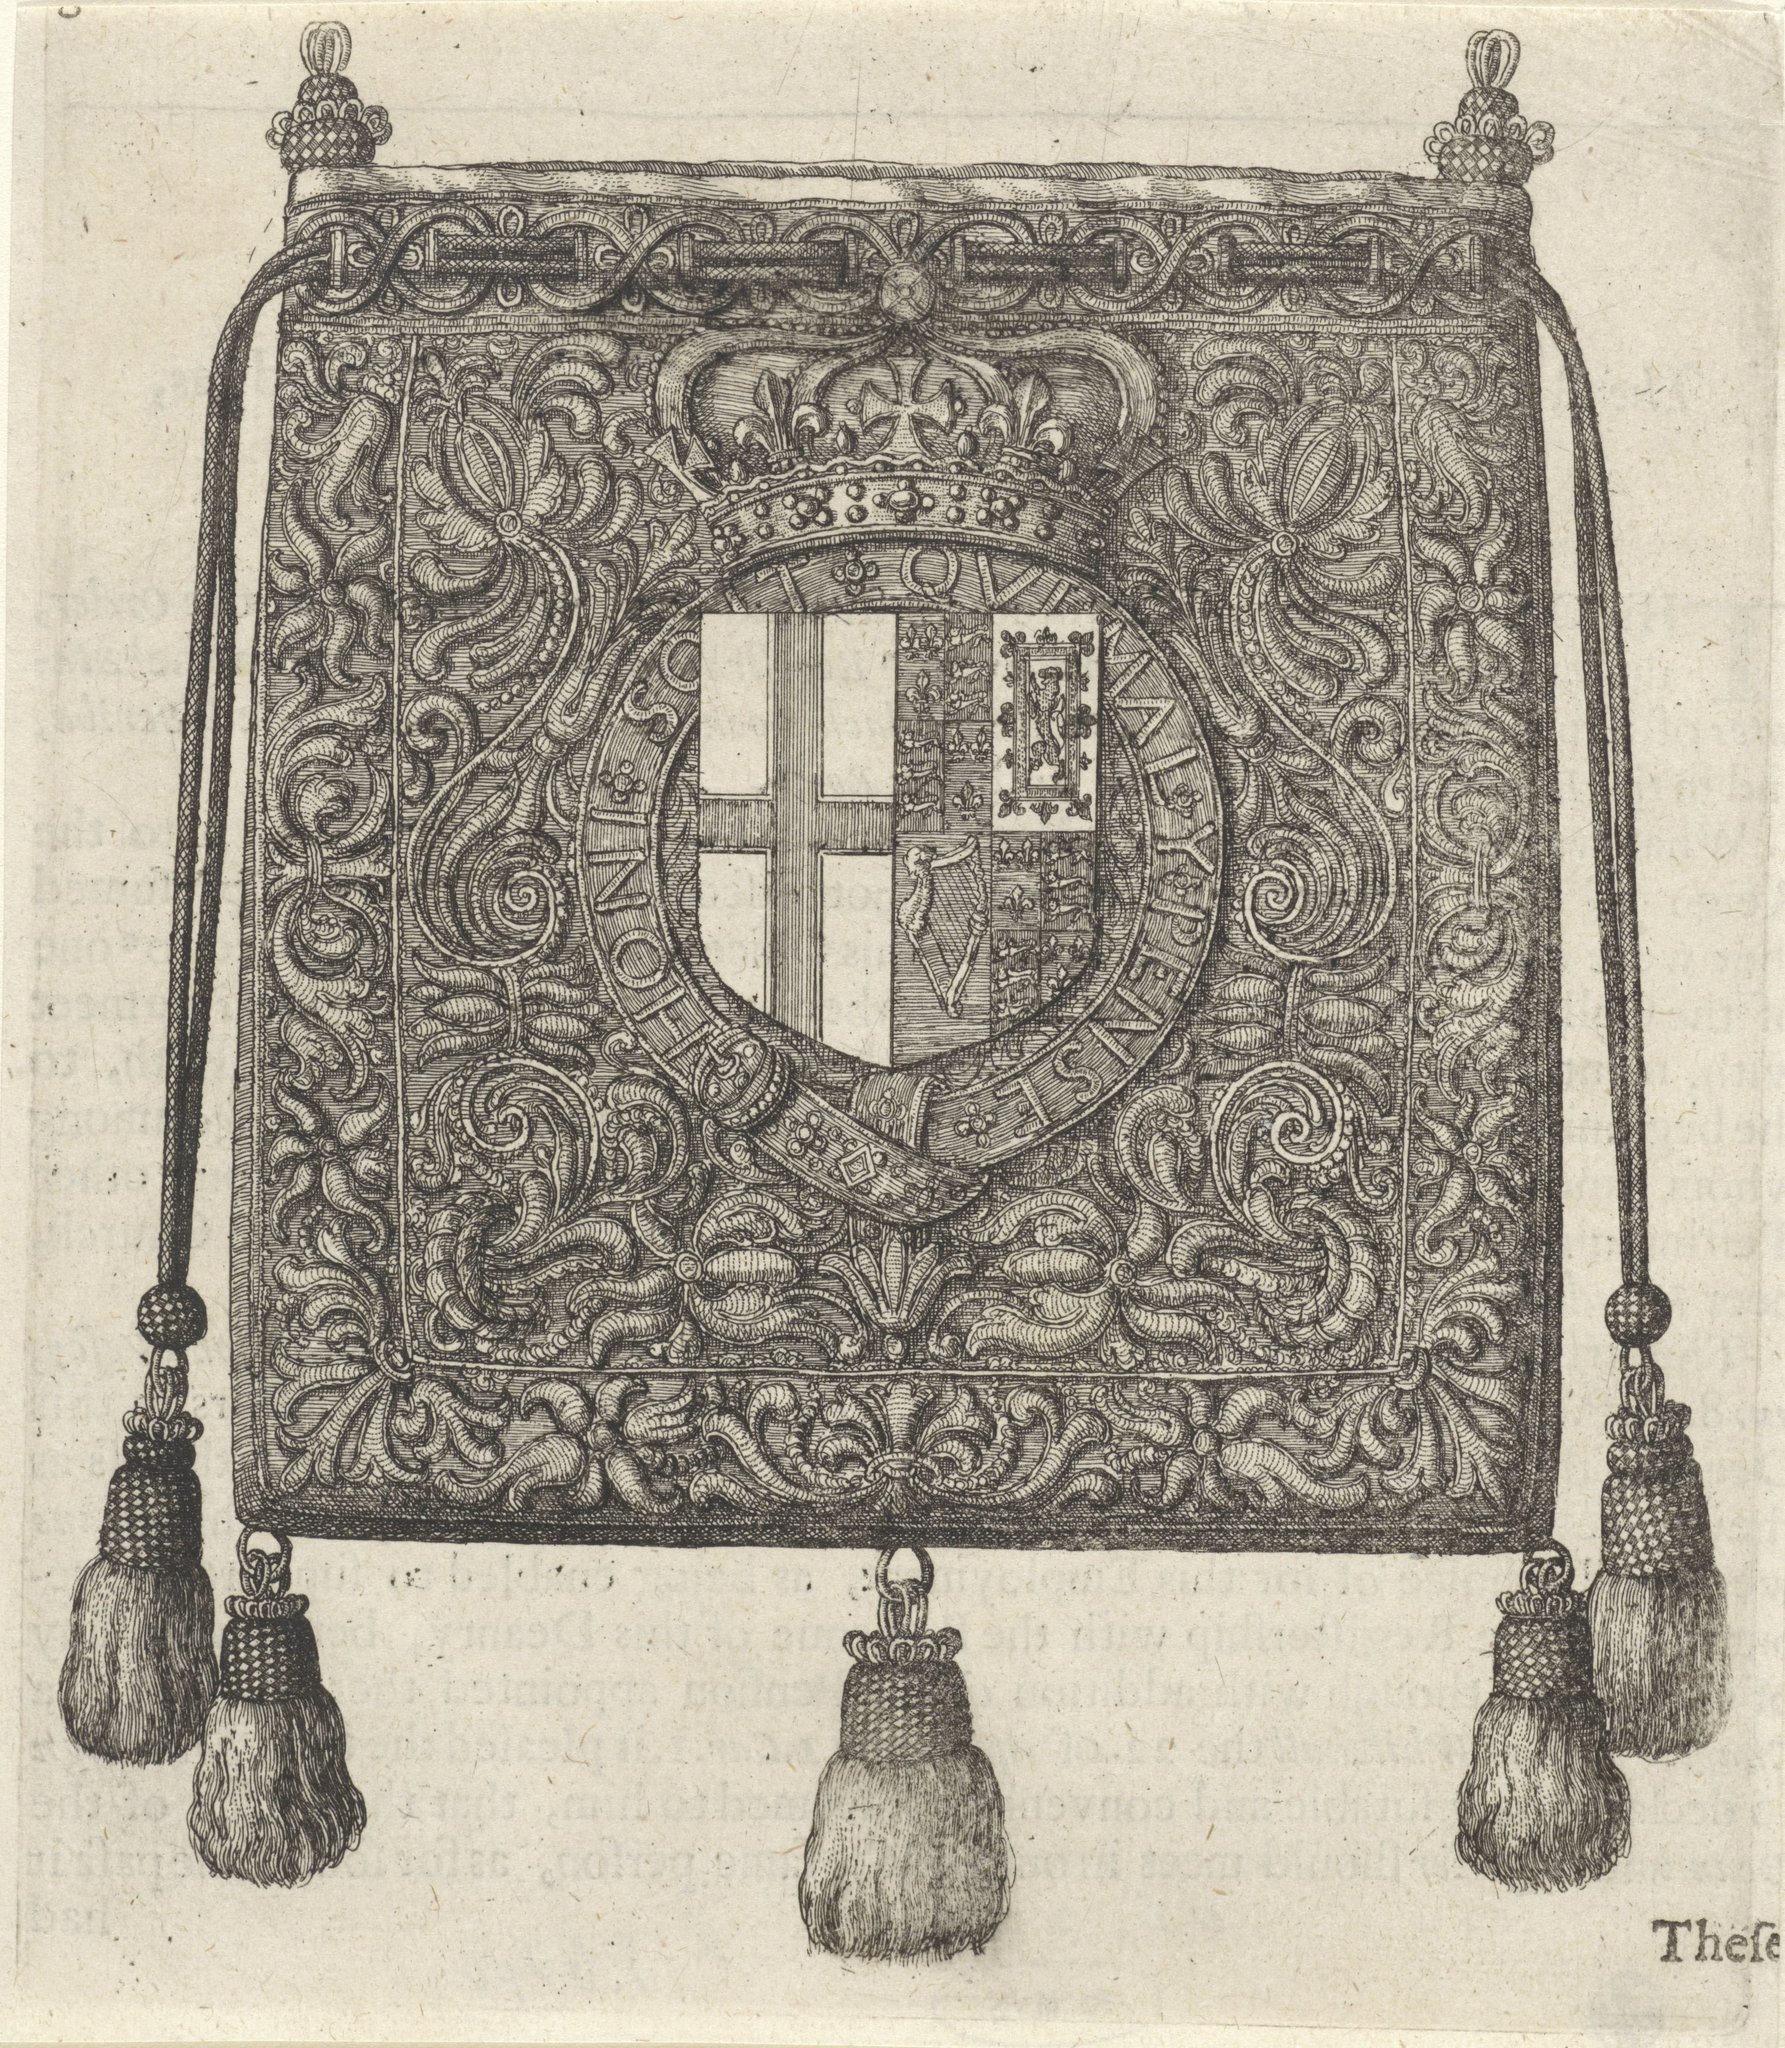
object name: book illustration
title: Tas met het wapen van de Orde van de Kousenband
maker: wenceslaus hollar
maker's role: draughtsman, print maker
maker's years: 1607-1677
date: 1672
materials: paper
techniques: etching, letterpress printing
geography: london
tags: knighthood order (garter)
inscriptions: collector's mark: Lugt 1337, collector's mark: Lugt 2228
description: Prent opgenomen in: Ashmole, Elias. Institution, Laws and Ceremonies of the Most Noble Order of the Garter, 1672, 1693.